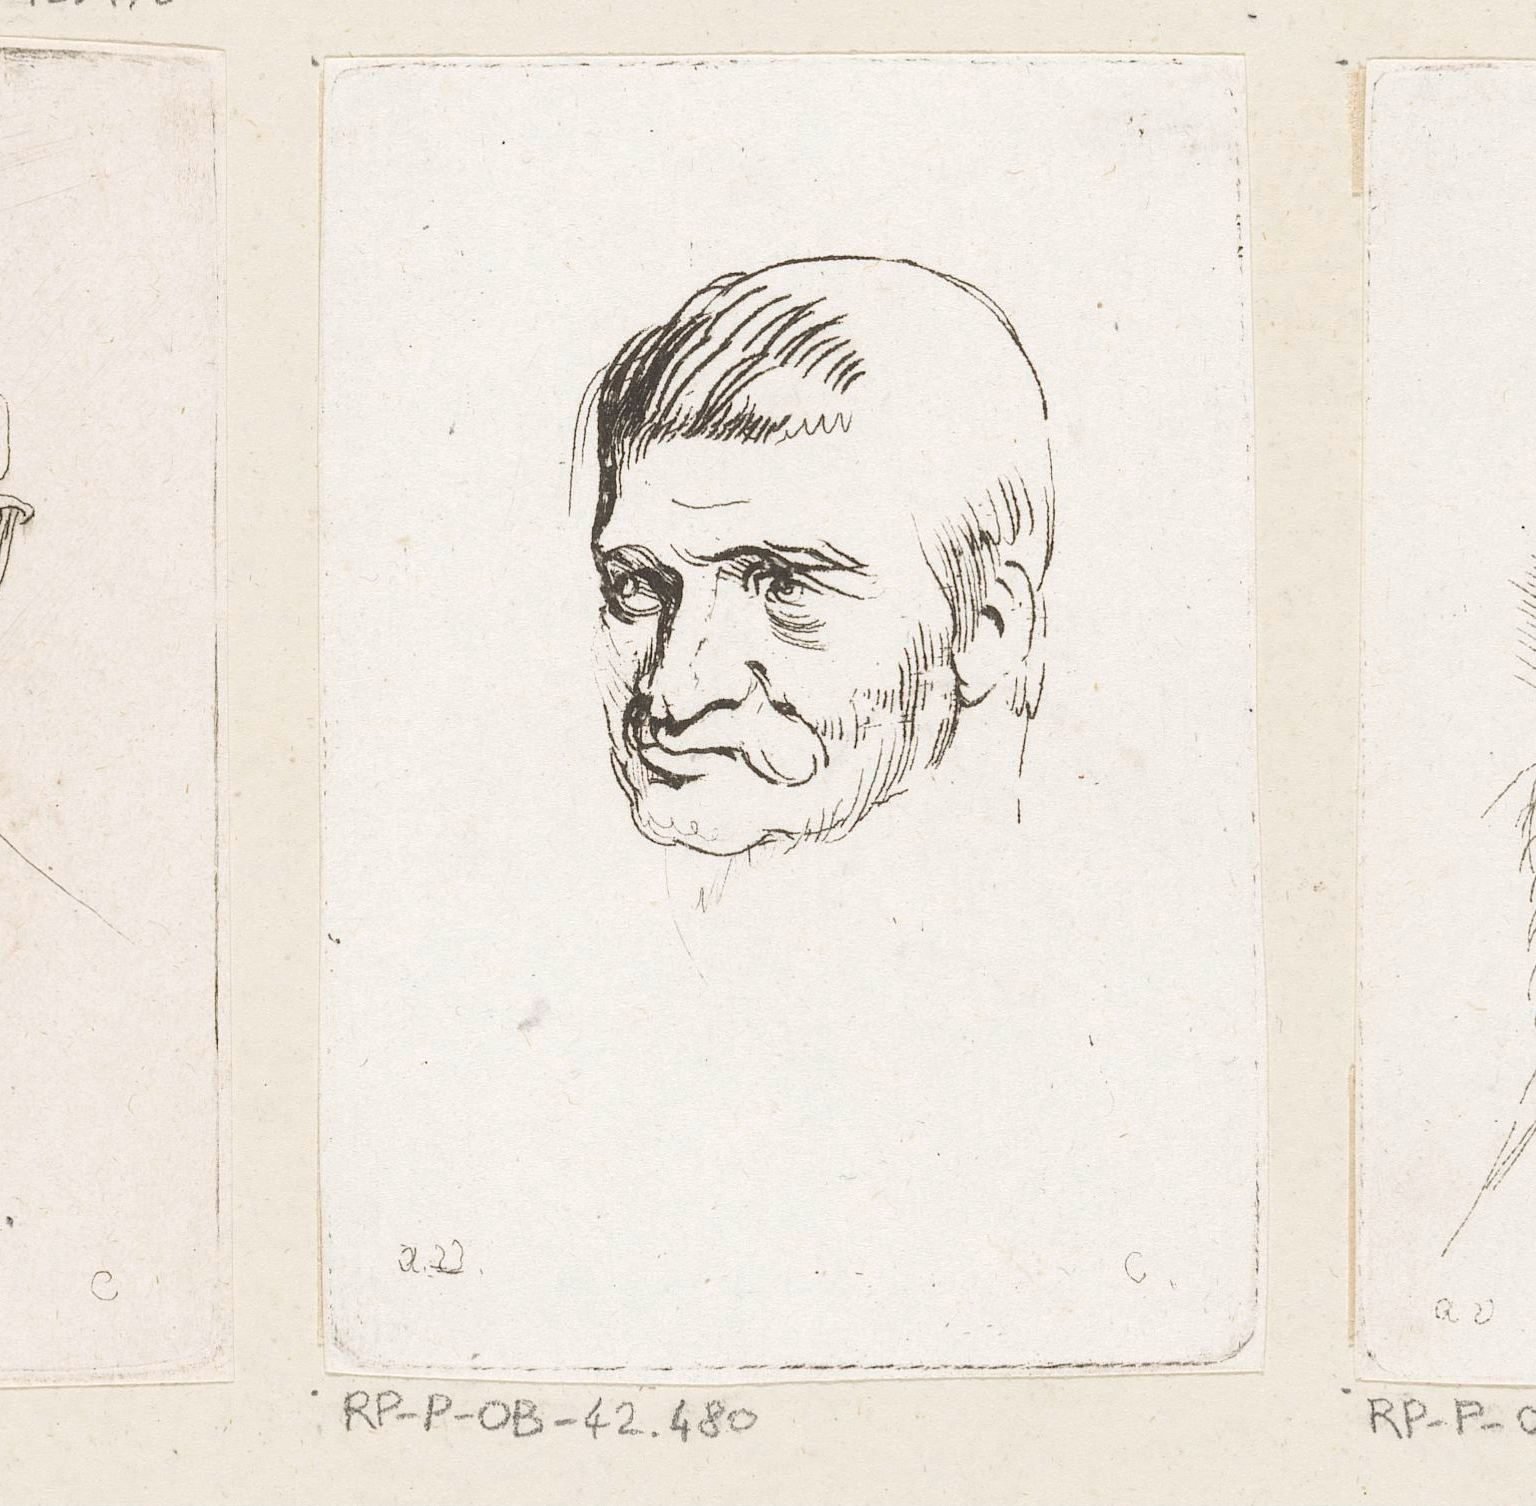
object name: print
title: Recueil de Testes d'Antoine Van Dyck (...)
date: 1735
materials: paper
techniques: etching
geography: france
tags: head (human), adult man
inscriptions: collector's mark: Lugt 240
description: Prent uit een serie van 31 prenten naar getekende hoofden door Van Dyck, plus een titelprent naar Bouchardon, getiteld: "Recueil de Testes d'Antoine Van Dyck tirées du Cabinet de M. Crozat et gravées par M. le C. de C.".